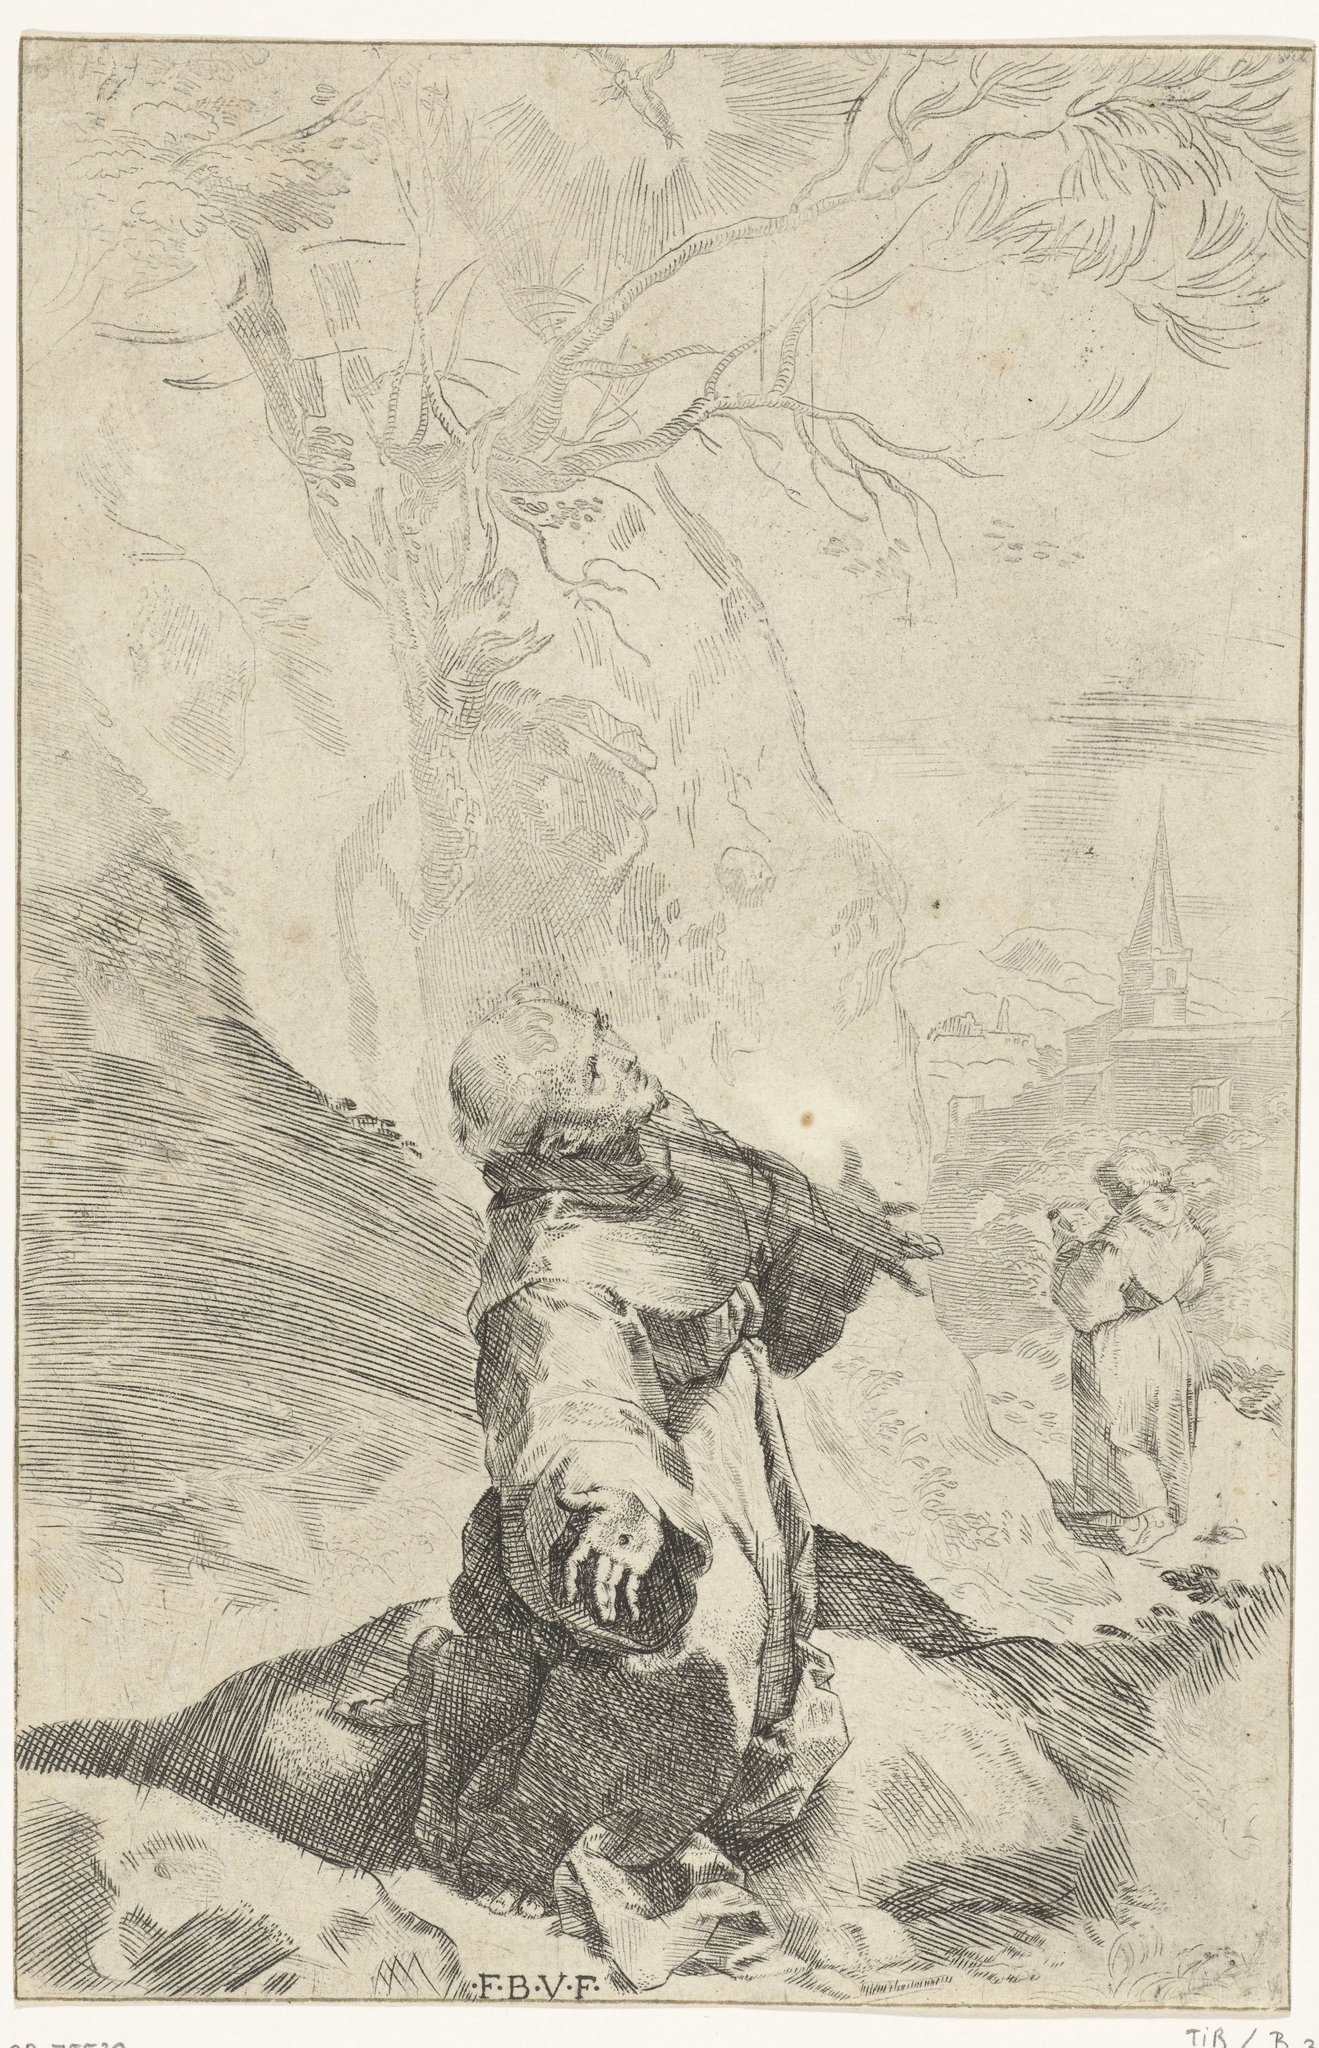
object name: print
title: Stigmatisatie van de Heilige Franciscus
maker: federico barocci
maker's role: draughtsman, painter, print maker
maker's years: 1528-1612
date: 1581-1585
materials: paper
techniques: drypoint, engraving, etching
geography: urbino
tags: stigmatization of st. francis of assisi: in retreat on mount alverna, he beholds a vision of christ on the cross enveloped by wings (like a seraph with six wings); rays passing down to the body of the kneeling saint form the marks of the five wounds of christ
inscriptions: collector's mark: Lugt 240, collector's mark: Lugt 2228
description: De Heilige Franciscus geknield bij een boom, de armen gespreid, de blik gericht op een crucifix boven hem aan de hemel. Op de achtergrond een broeder op de rug gezien, al lezend terwijl hij in de richting van een kerkje wandelt.